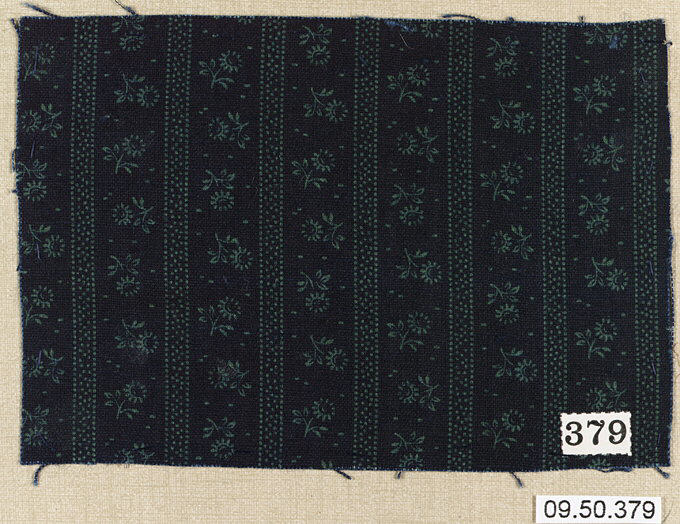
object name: piece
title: Piece (one of 116)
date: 1801-1900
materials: cotton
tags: flowers,leaves